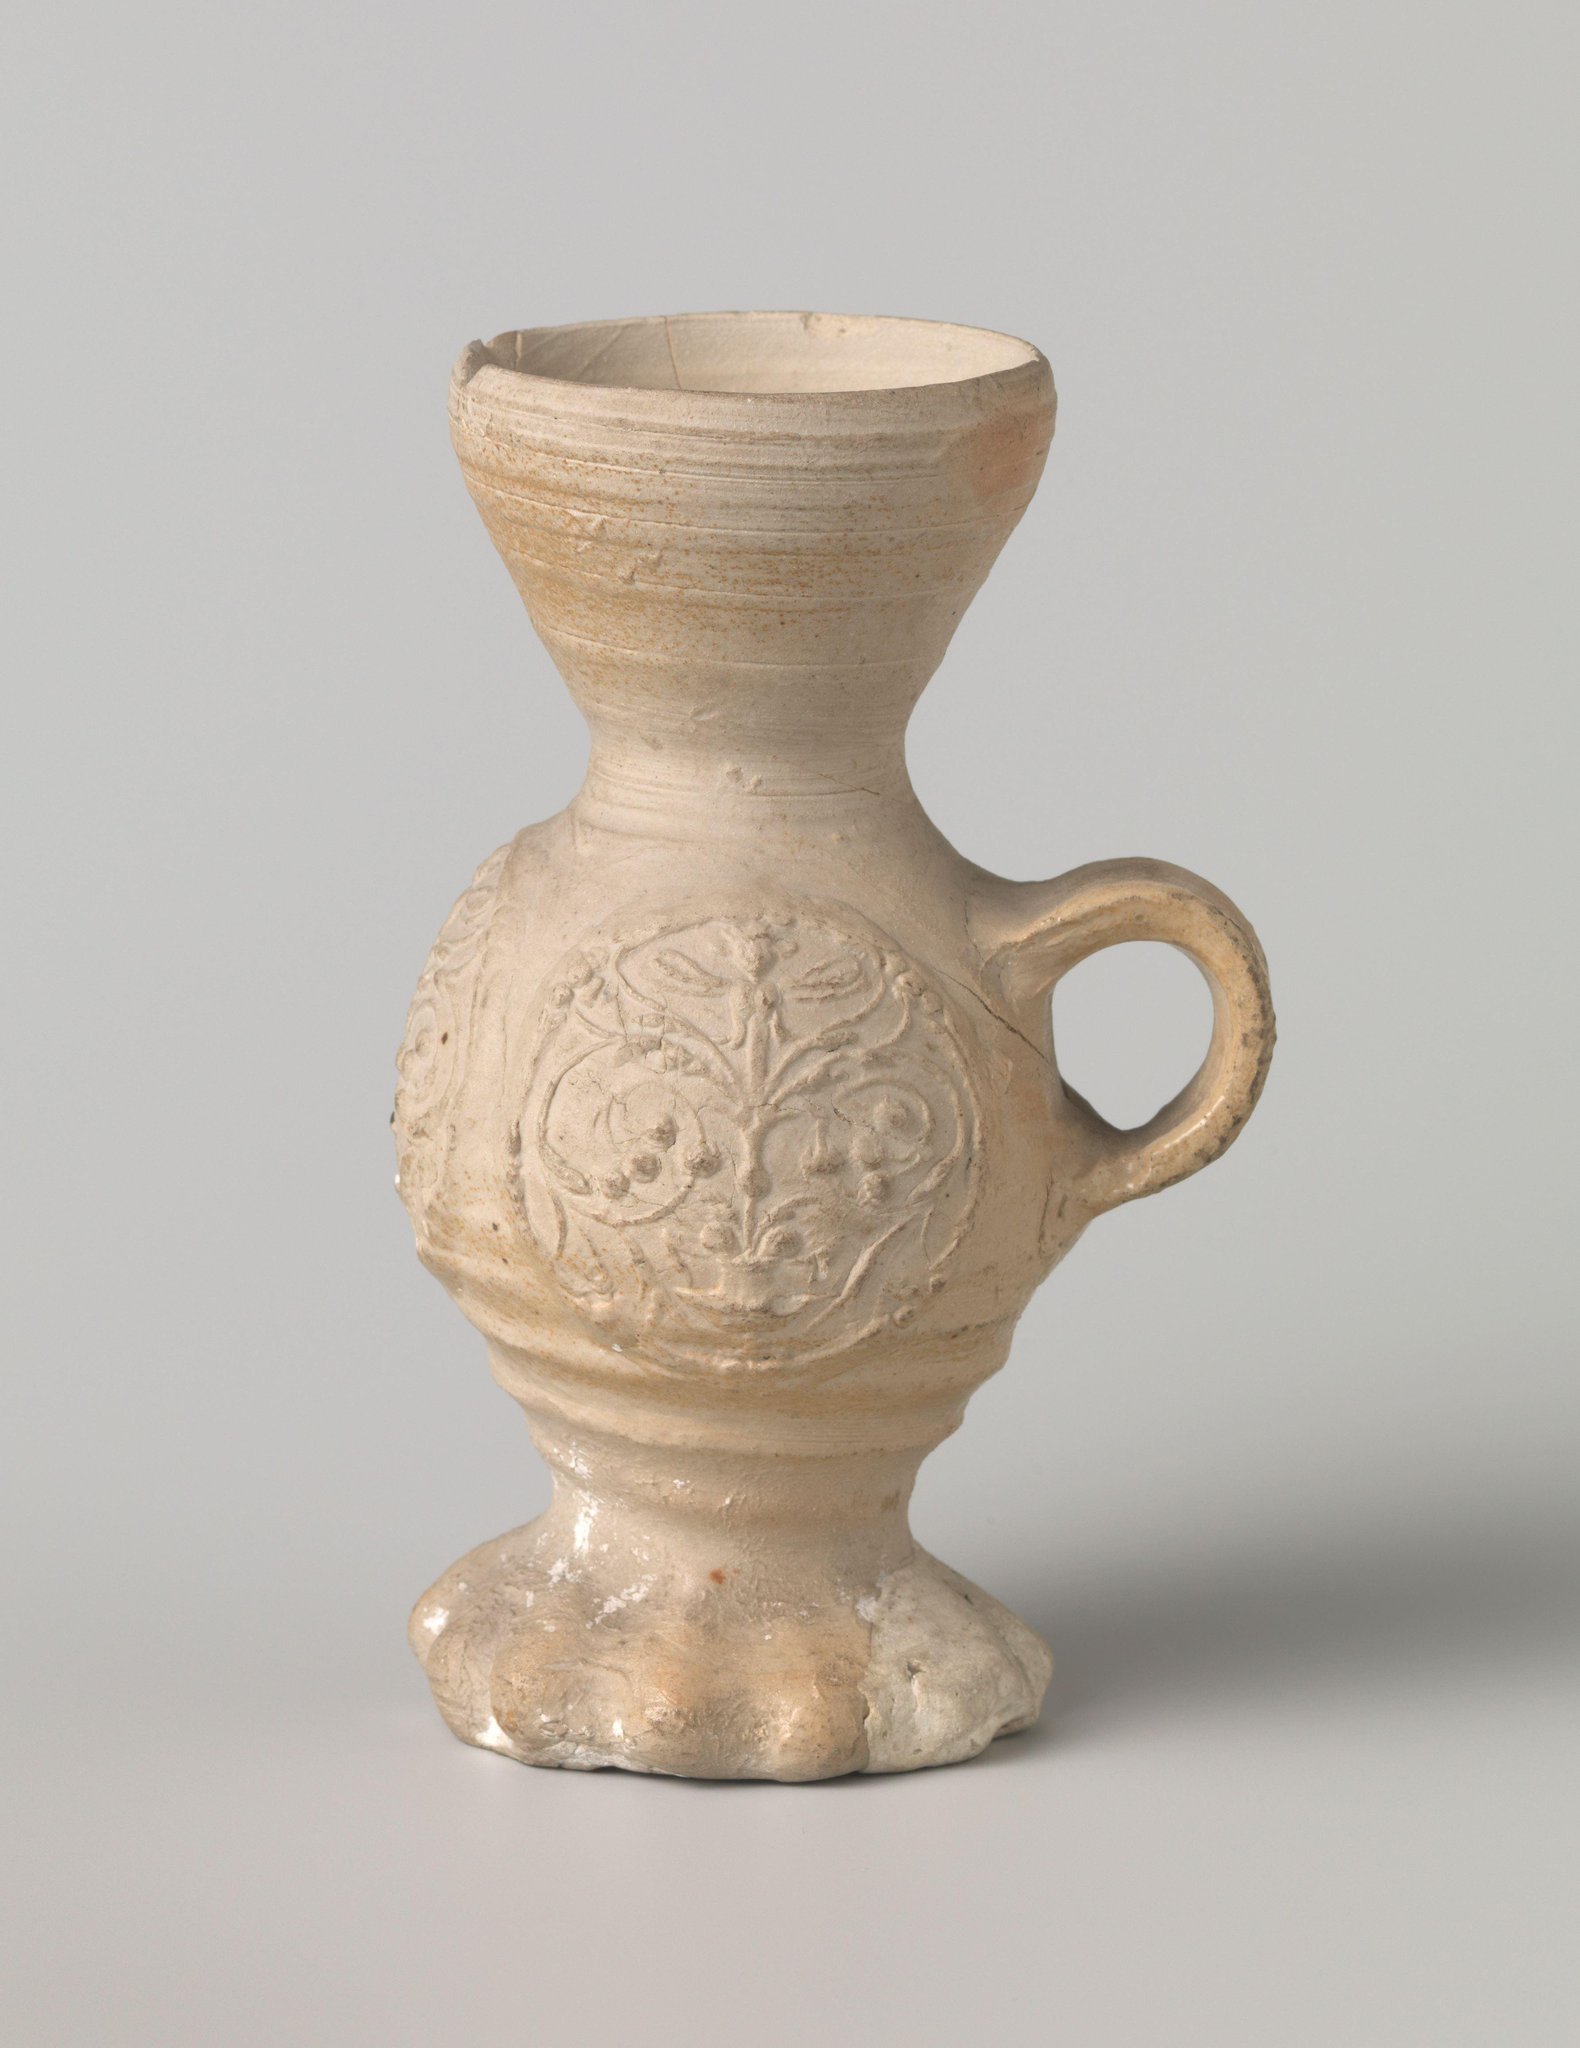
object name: cup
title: Beaker 'trichterhalsbecher' with the Expulsion from Paradise and floral scrolls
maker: Anonymous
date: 1560-1590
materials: glaze, stoneware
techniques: firing, forming, relief, turning, vitrification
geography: siegburg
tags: zutphen (stad)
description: Beker (trechterhalsbeker) van steengoed op golvende voet met een eivormig lichaam en trechtervormige nek. Het C-vormige oor is bevestigd aan de schouder en buik. De beker is versierd met draairingen, waarbij de schouder is gladgestreken. Op de buik in reliëf driemaal een gedrukt en opgelegd medaillon met in één de Verdrijving uit het Paradijs; de andere twee met bloemranken en een engel. Siegburg.